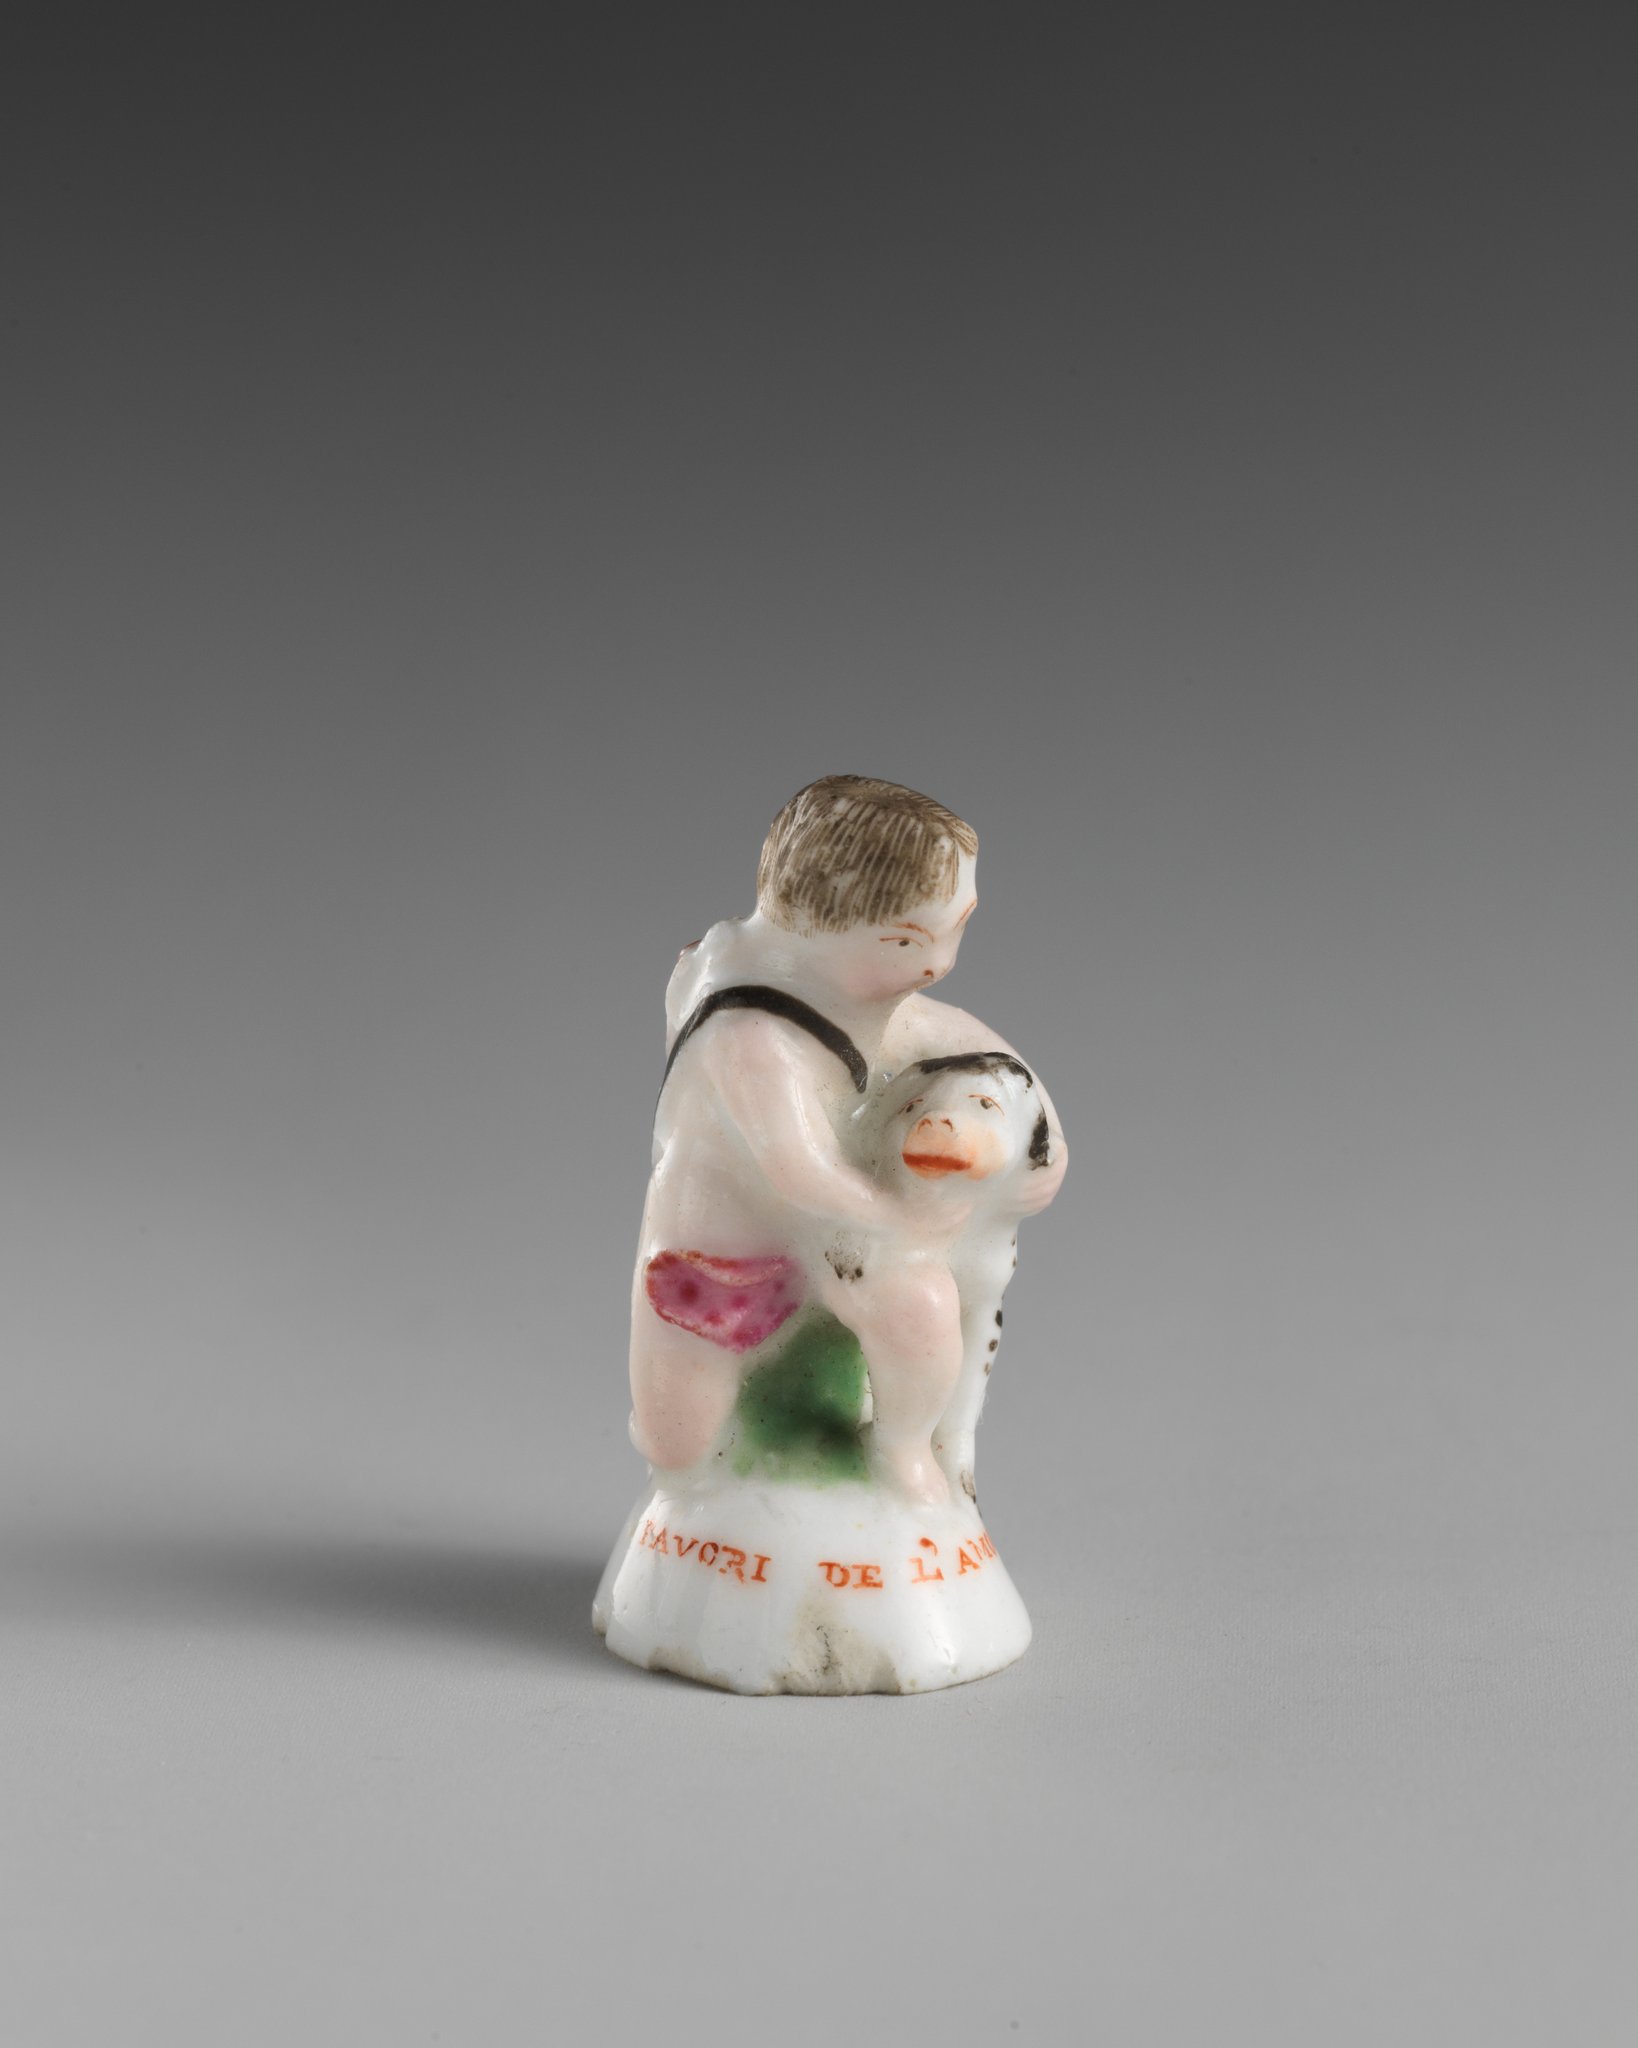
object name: seal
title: Miniature seal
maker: chelsea porcelain manufactory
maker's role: factory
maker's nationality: british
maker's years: 1744-1784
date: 1753-1758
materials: soft paste porcelain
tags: cupid,dogs